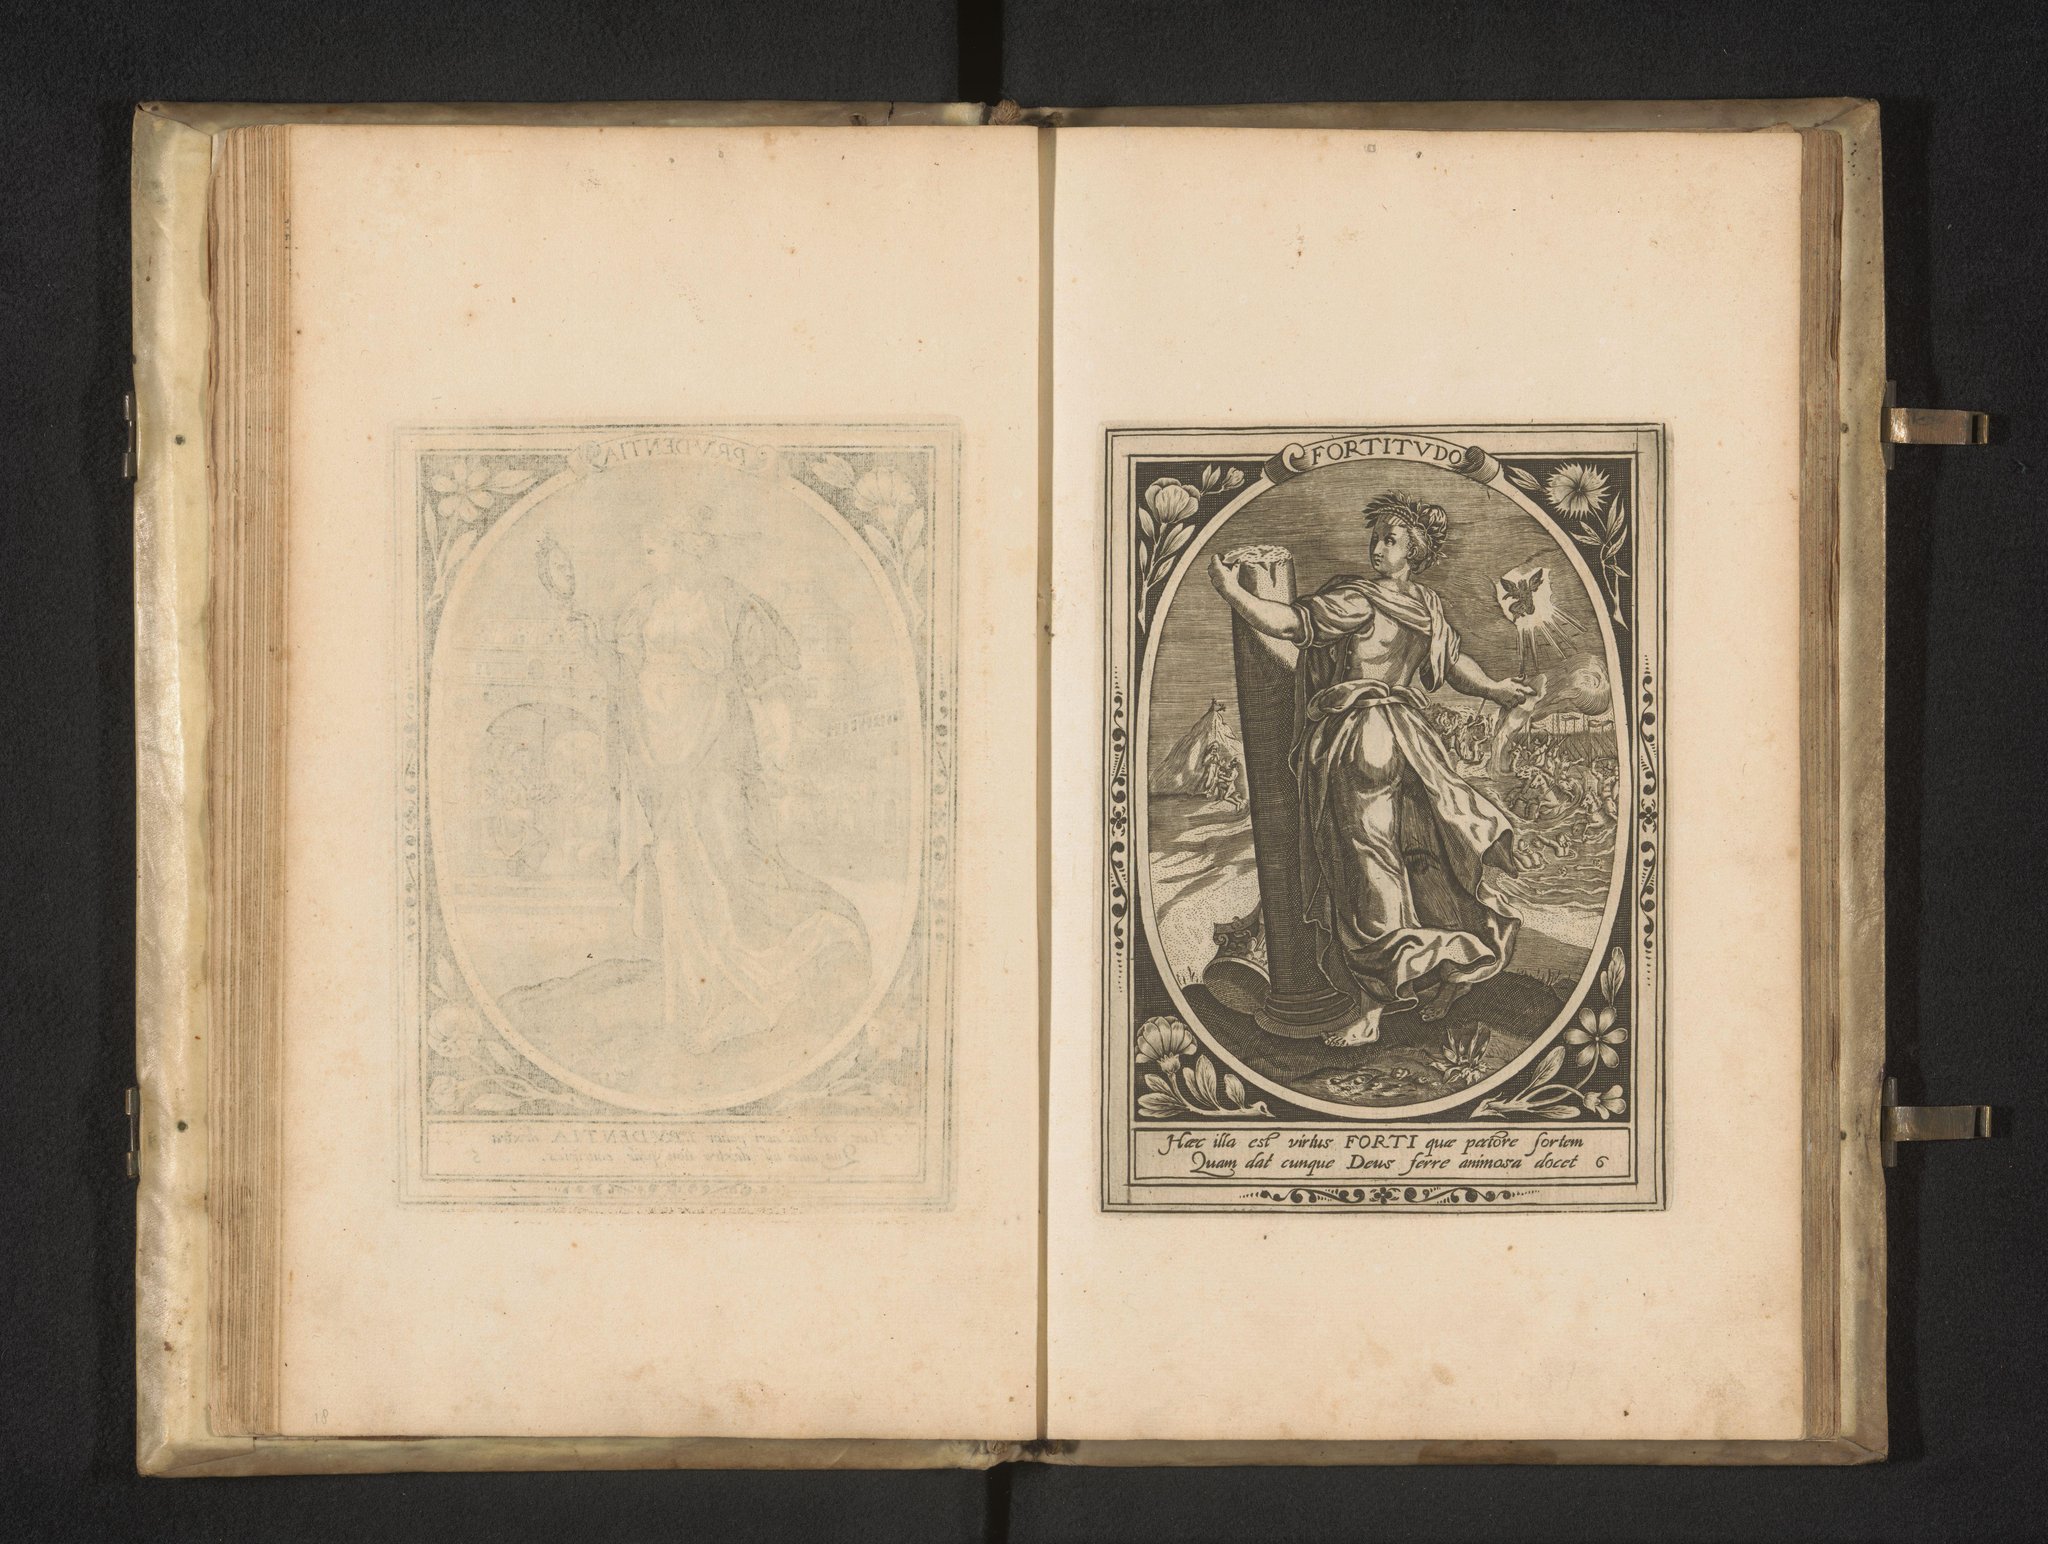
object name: print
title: VII Virtutum Theologicarum et Cardinalium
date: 1600-1670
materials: paper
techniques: engraving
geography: paris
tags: fortitude, 'fortitudo' ~ one of the four cardinal virtues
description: De Kracht (Fortitudo). Genummered rechtsonder: 6. Onderdeel van de serie van zeven theologische en kardinale deugden. Onderdeel van een album met voornamelijk christelijke voorstellingen.